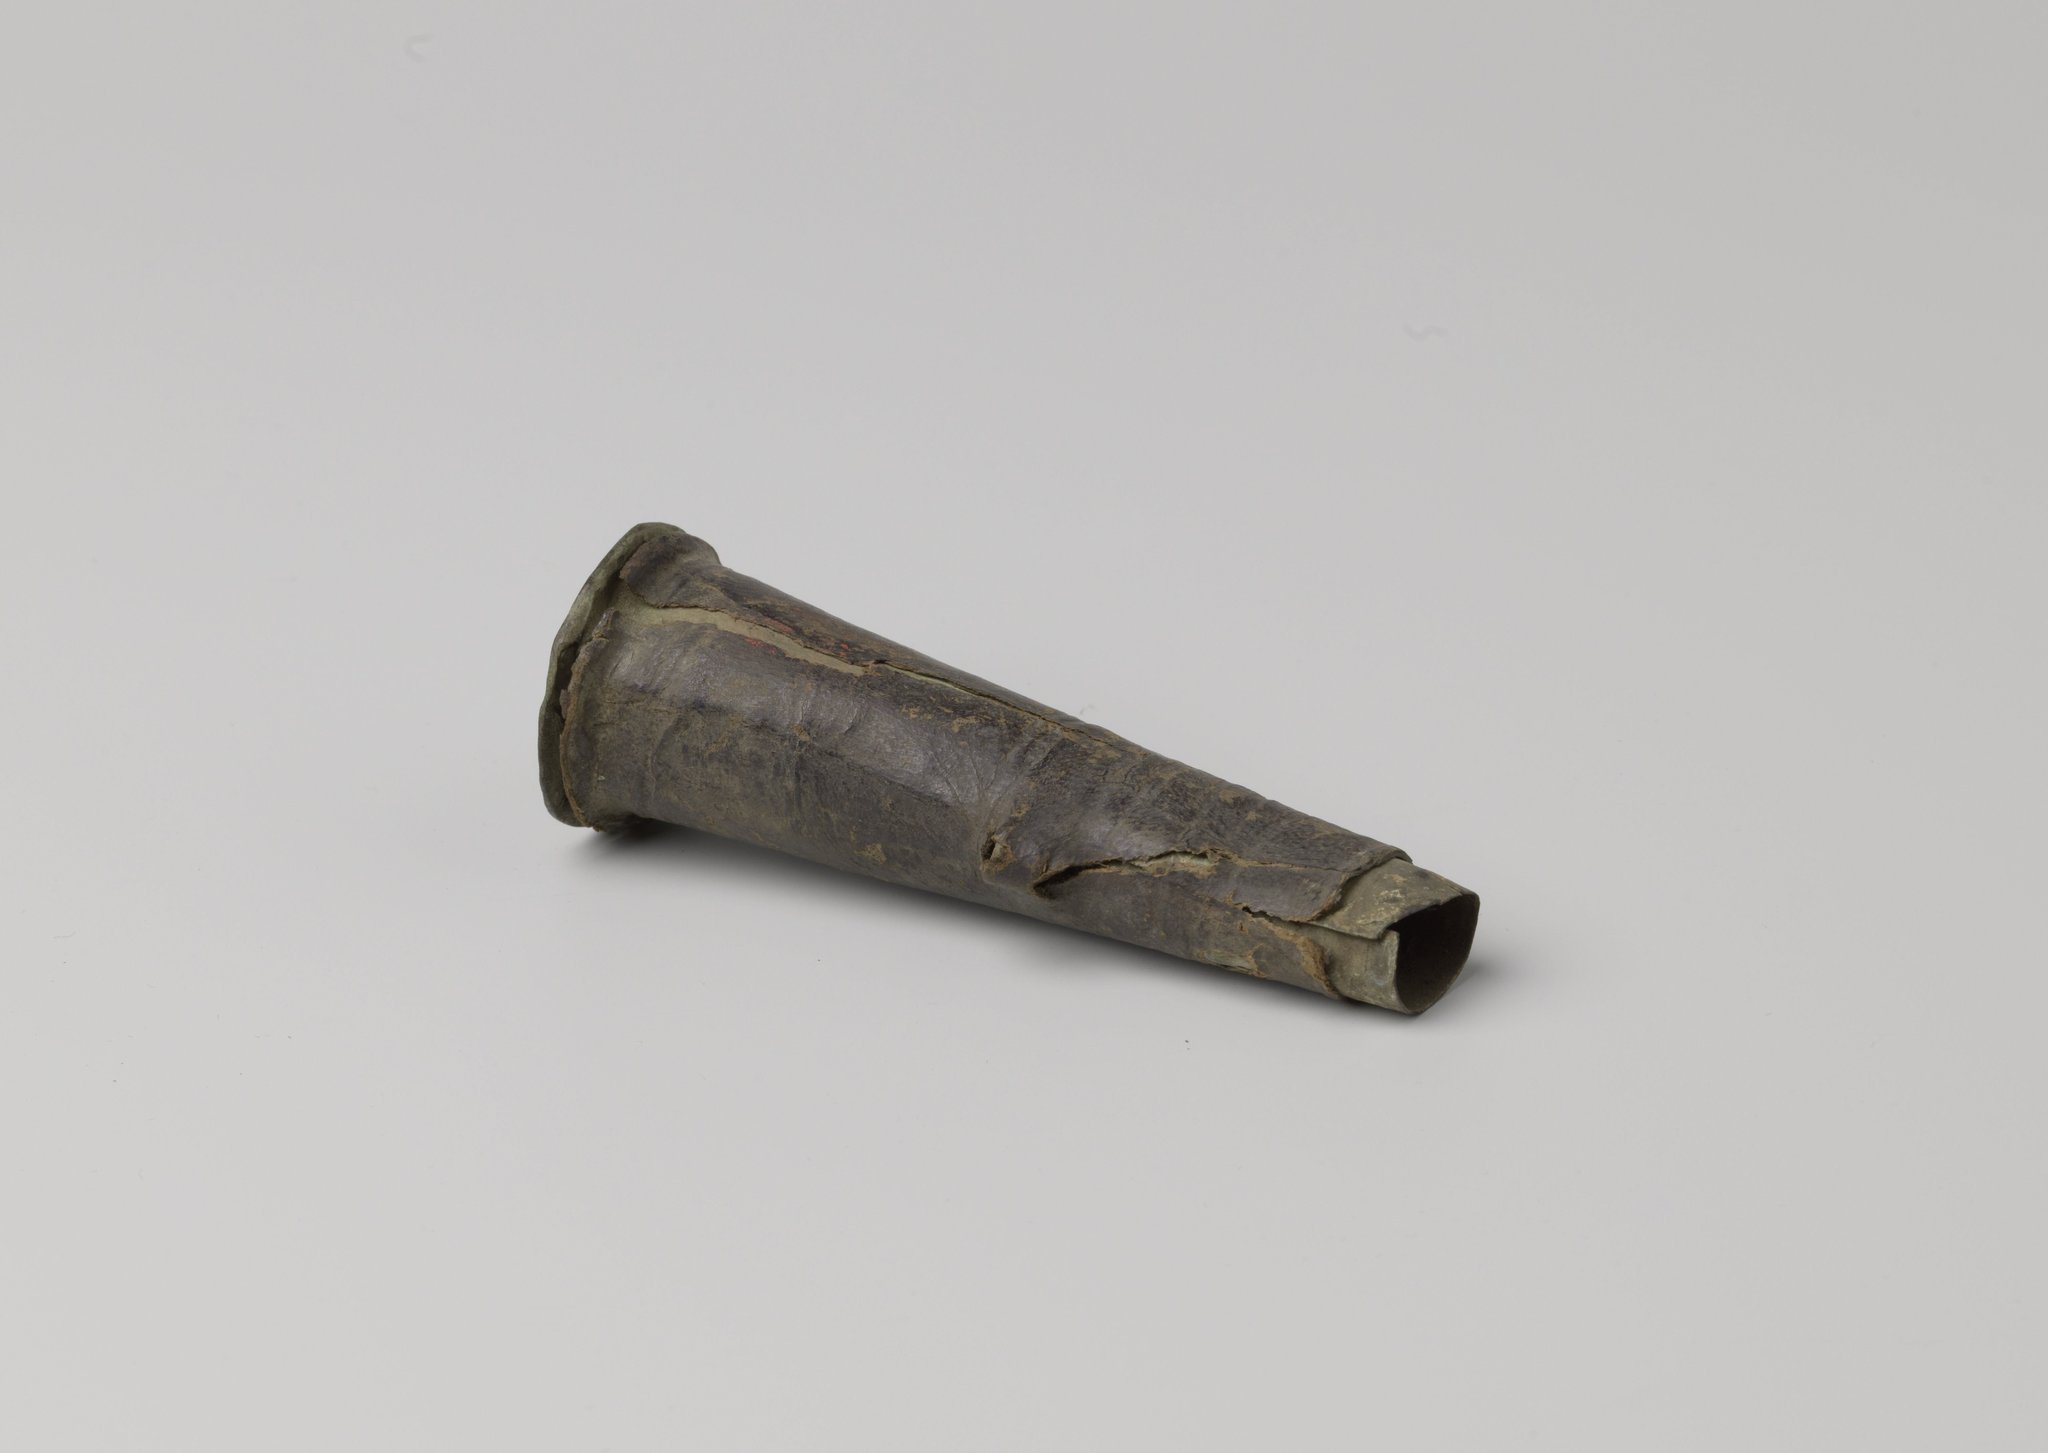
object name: kruitmaat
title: Musketmaat van messing met een leren huls en leren oortjes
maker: Anonymous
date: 1590-1596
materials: brass, leather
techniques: striking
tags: willem barendsz., jacob van heemskerck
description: Musketmaat van messing met een leren huls en leren oortjes. De musketmaat heeft alleen messing aan de onderkant.